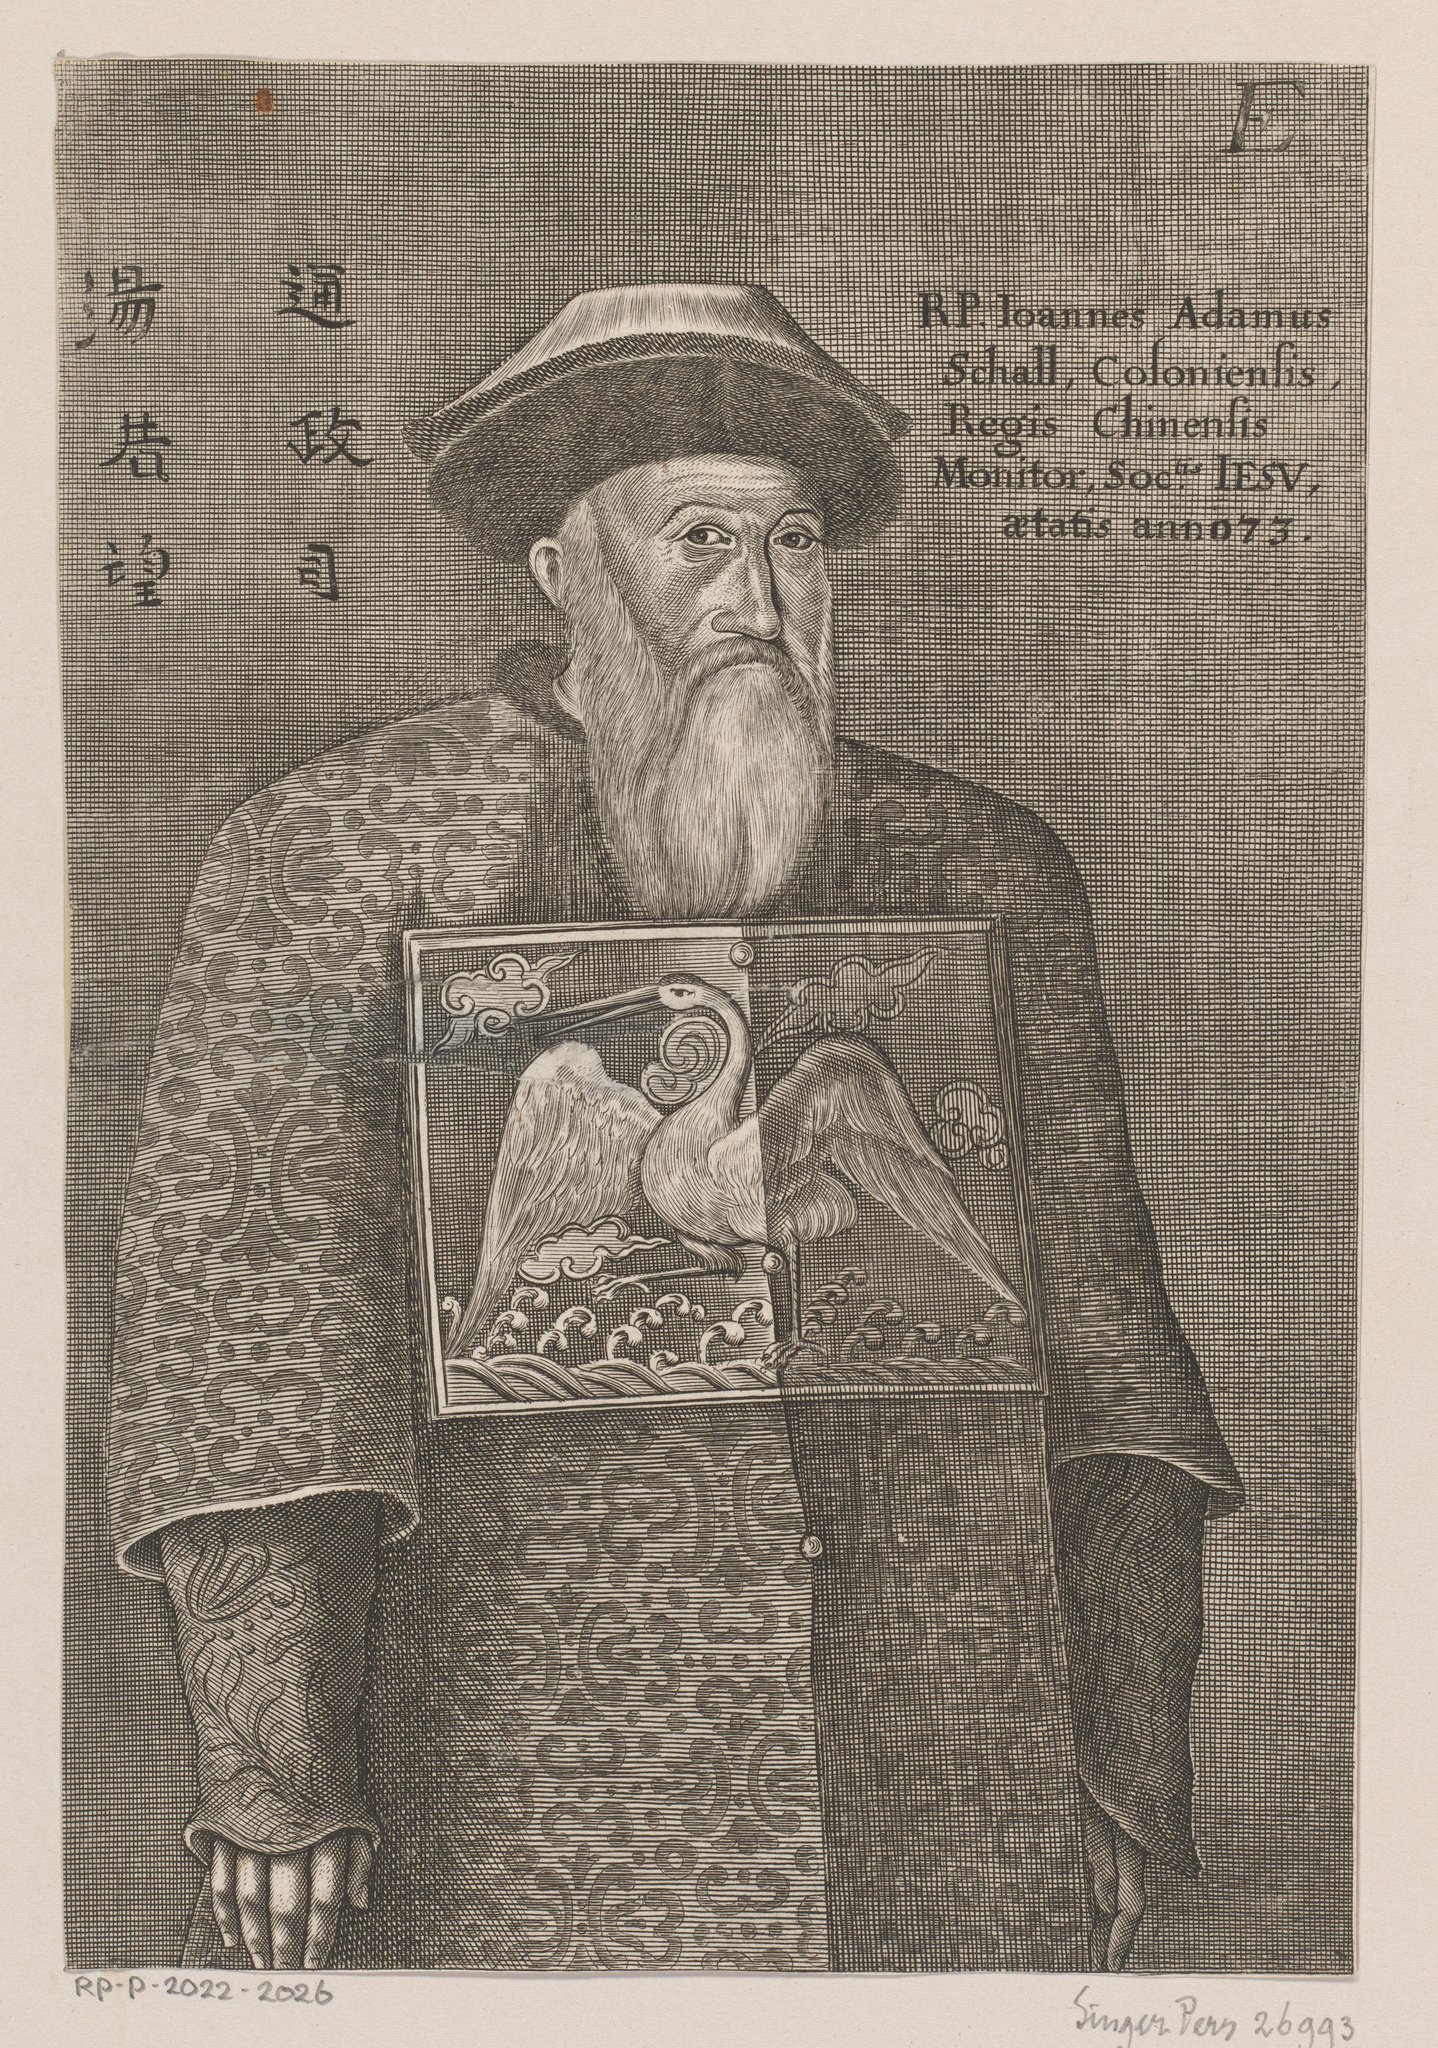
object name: print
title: Portret van Johann Adam Schall von Bell op 73-jarige leeftijd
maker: Anonymous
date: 1655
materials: paper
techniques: engraving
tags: missionary, historical persons, mathematics (+ portrait of scholar, scientist), spreading the gospel; missionary work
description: Met vijfregelige tekst in het Latijn en tekst in het Chinees.